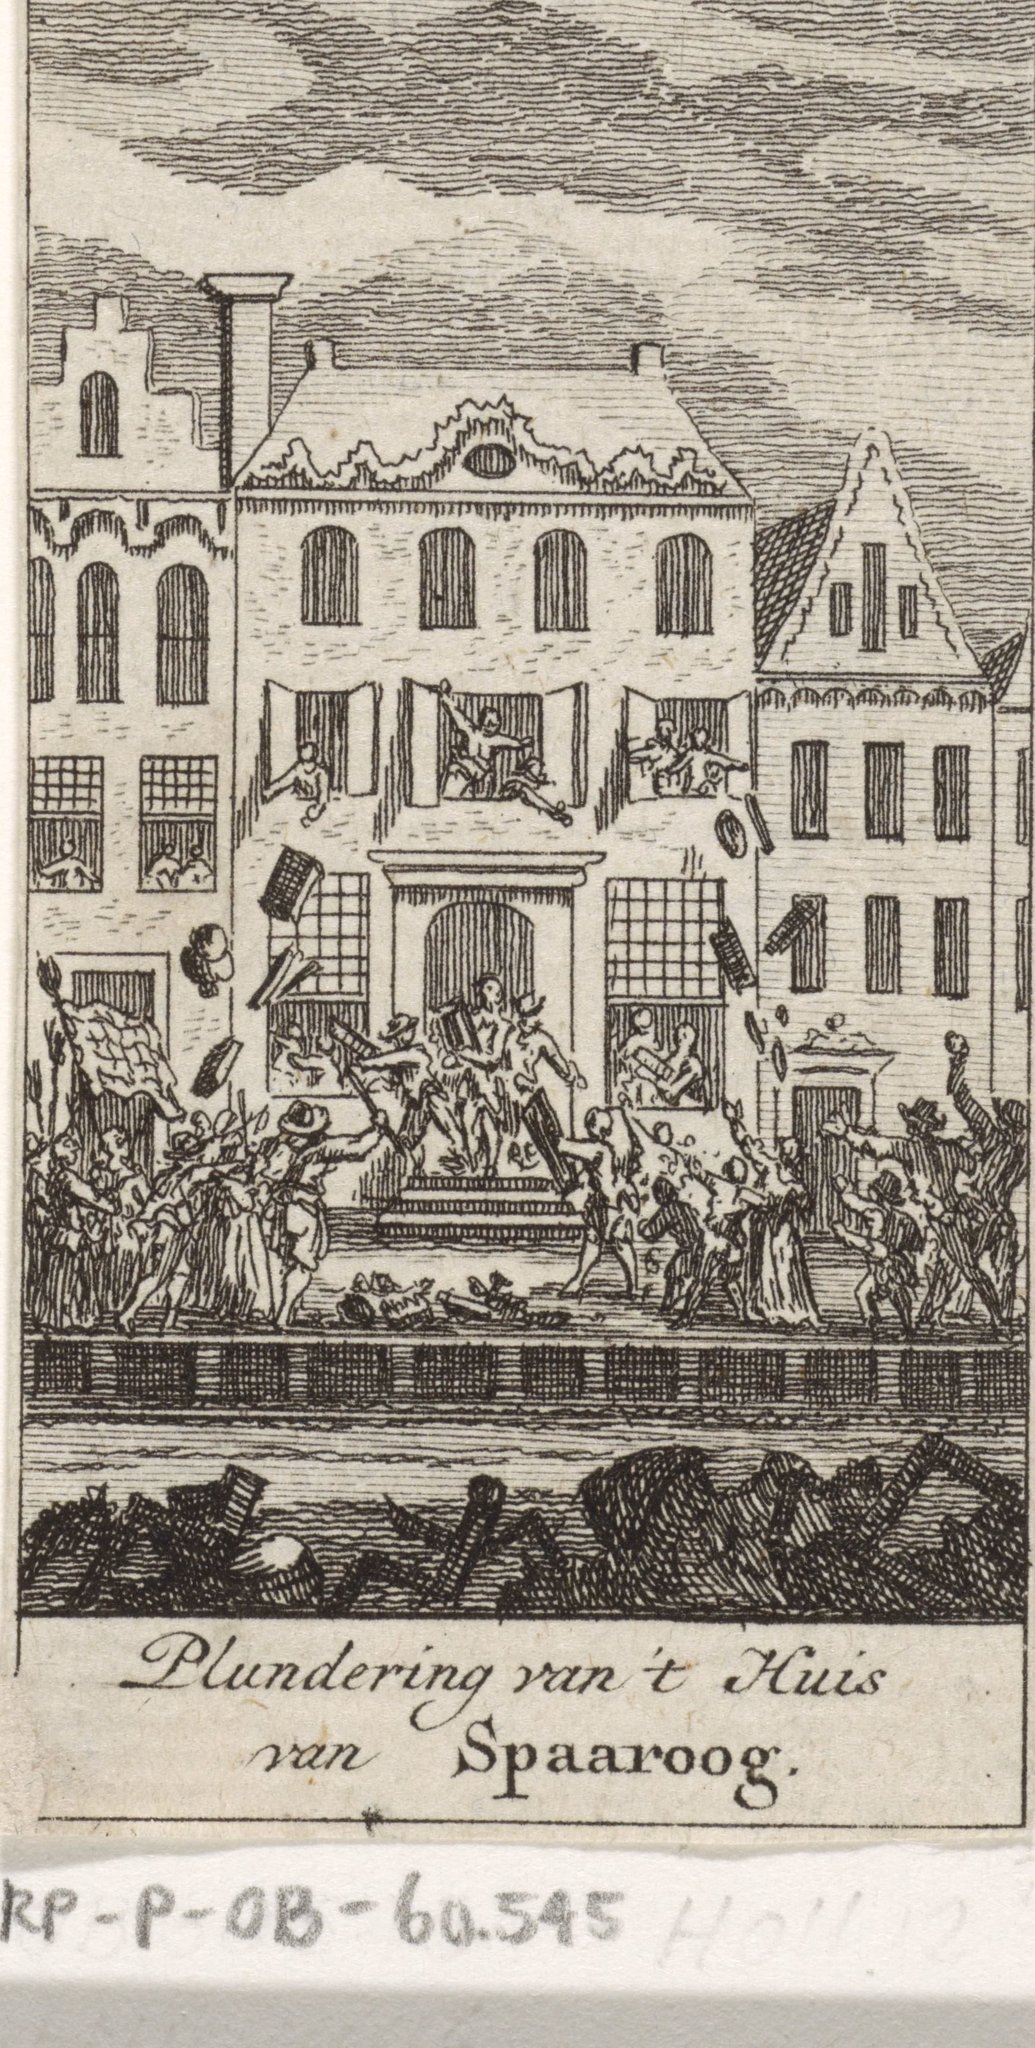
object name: book illustration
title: Plundering van 't Huis van Spaaroog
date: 1781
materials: paper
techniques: etching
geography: amsterdam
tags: plundering ~ riot, amsterdam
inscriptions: collector's mark: Lugt 2228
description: De prent is als boekillustratie gebruikt in: Kok, Jacobus. Amsteldamsche jaarboeken, behelzende de merkwaardigste geschiedenissen, welken, zo binnen de stad als daaromtrent, zijn voorgevallen, sedert haare eerste beginselen, tot op den tegenwoordigen tijd..., Amsterdam: Jan Barend Elwe, 1781.